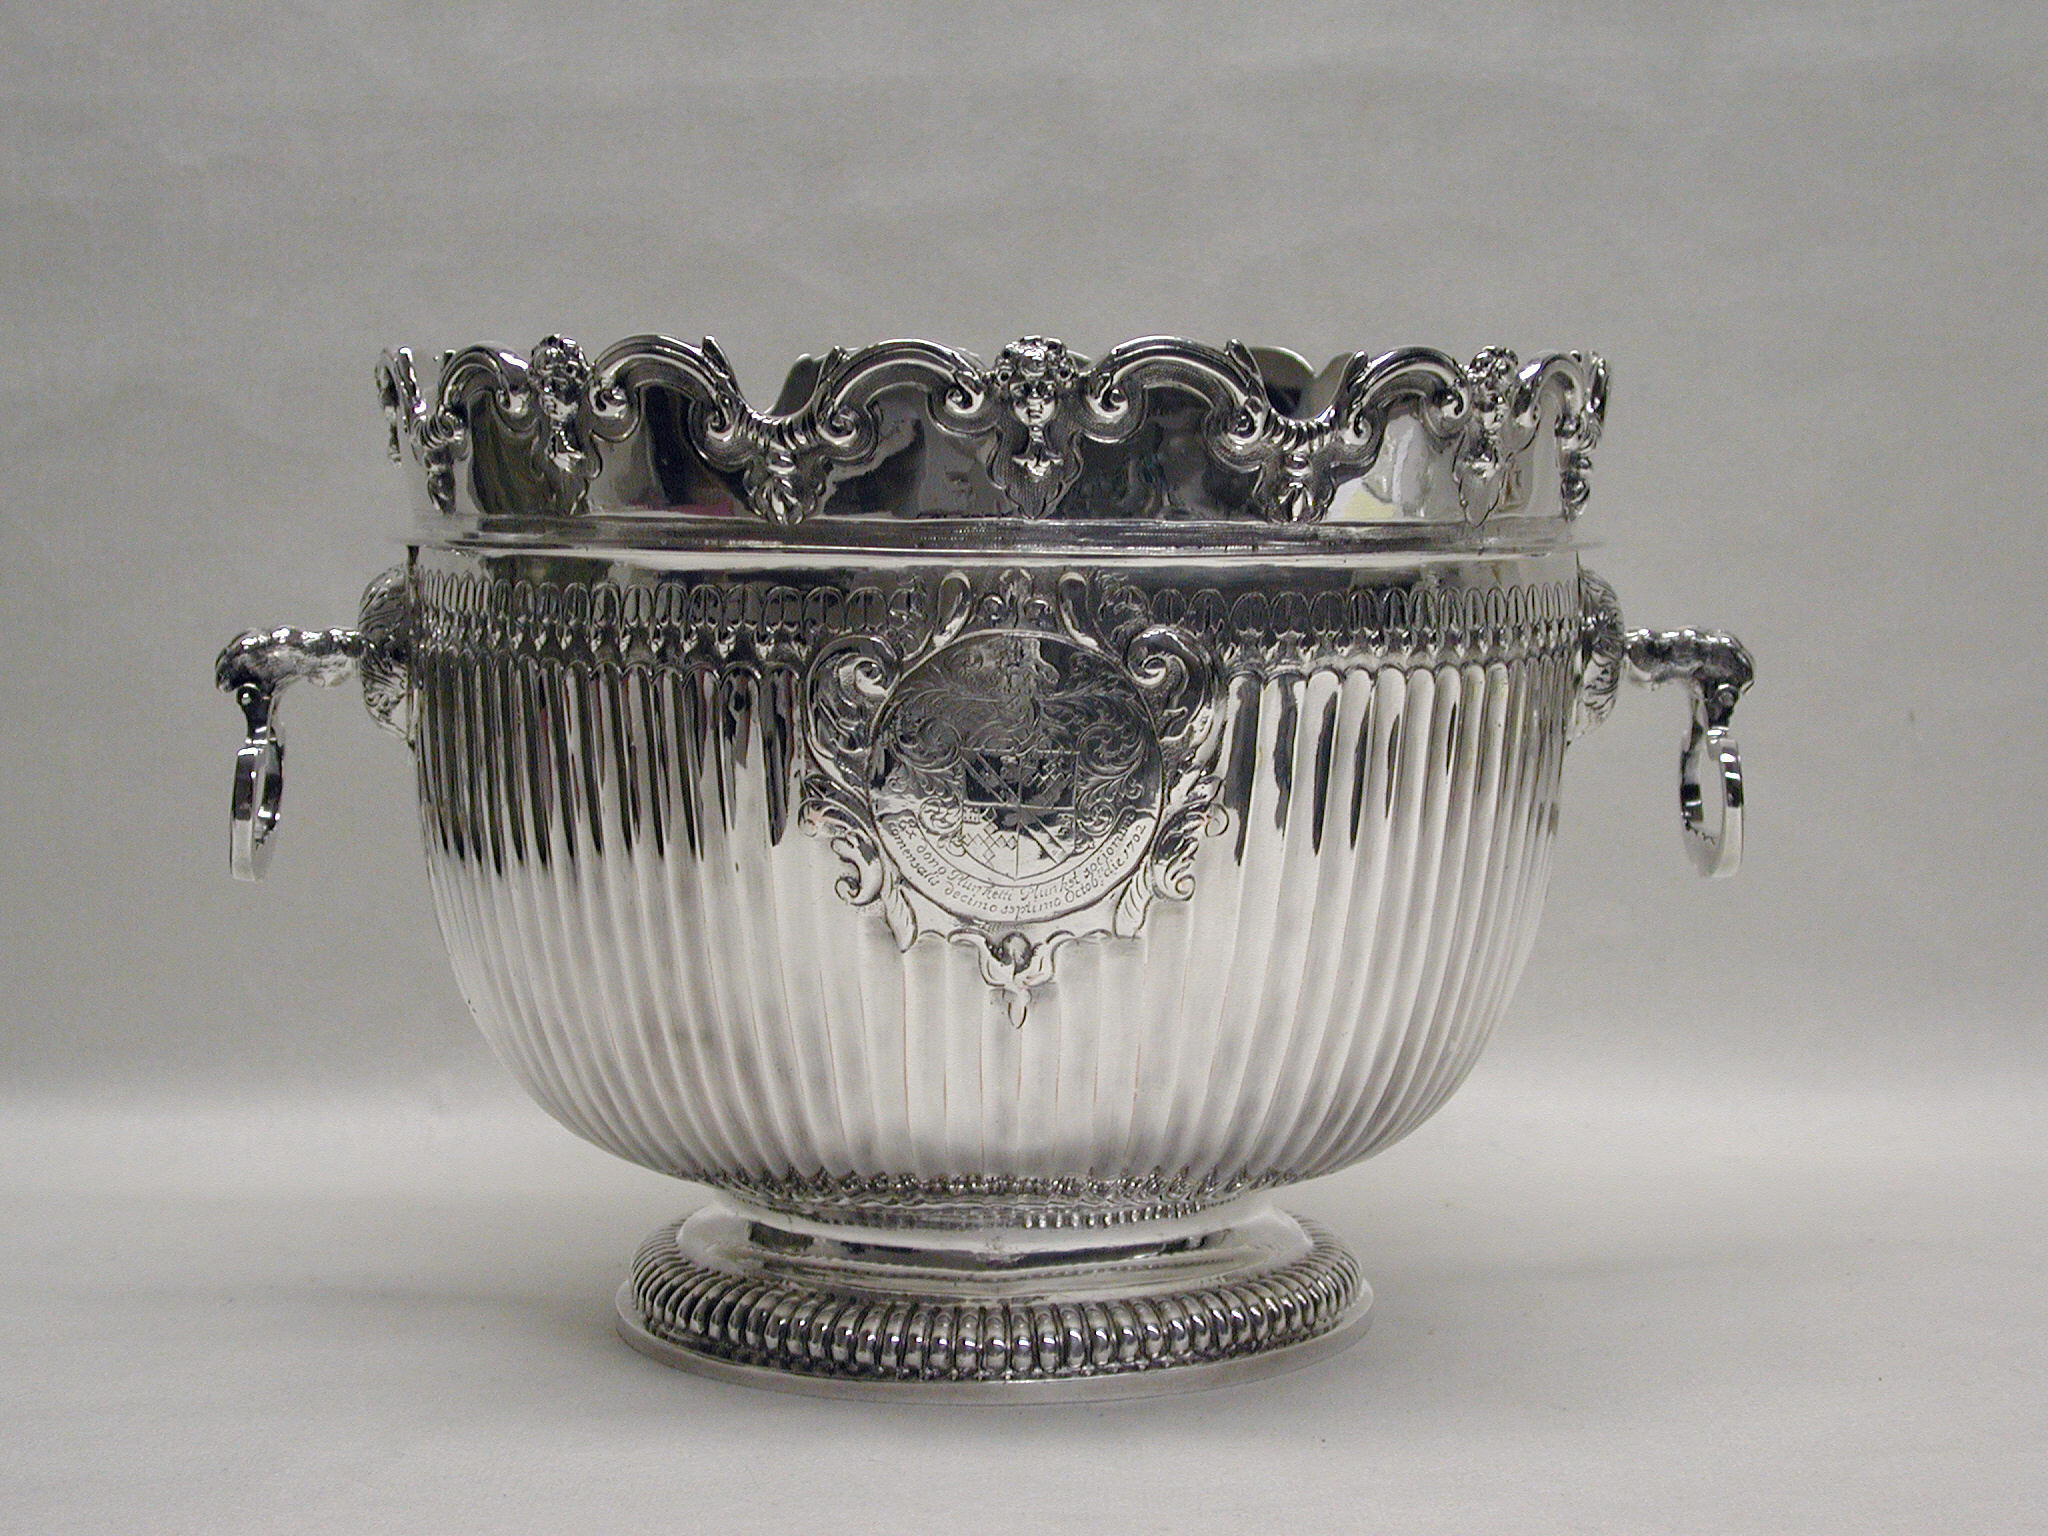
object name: monteith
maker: elkington & co.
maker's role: manufacturer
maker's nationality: british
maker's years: 1829-1963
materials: metal, silver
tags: horses,coat of arms